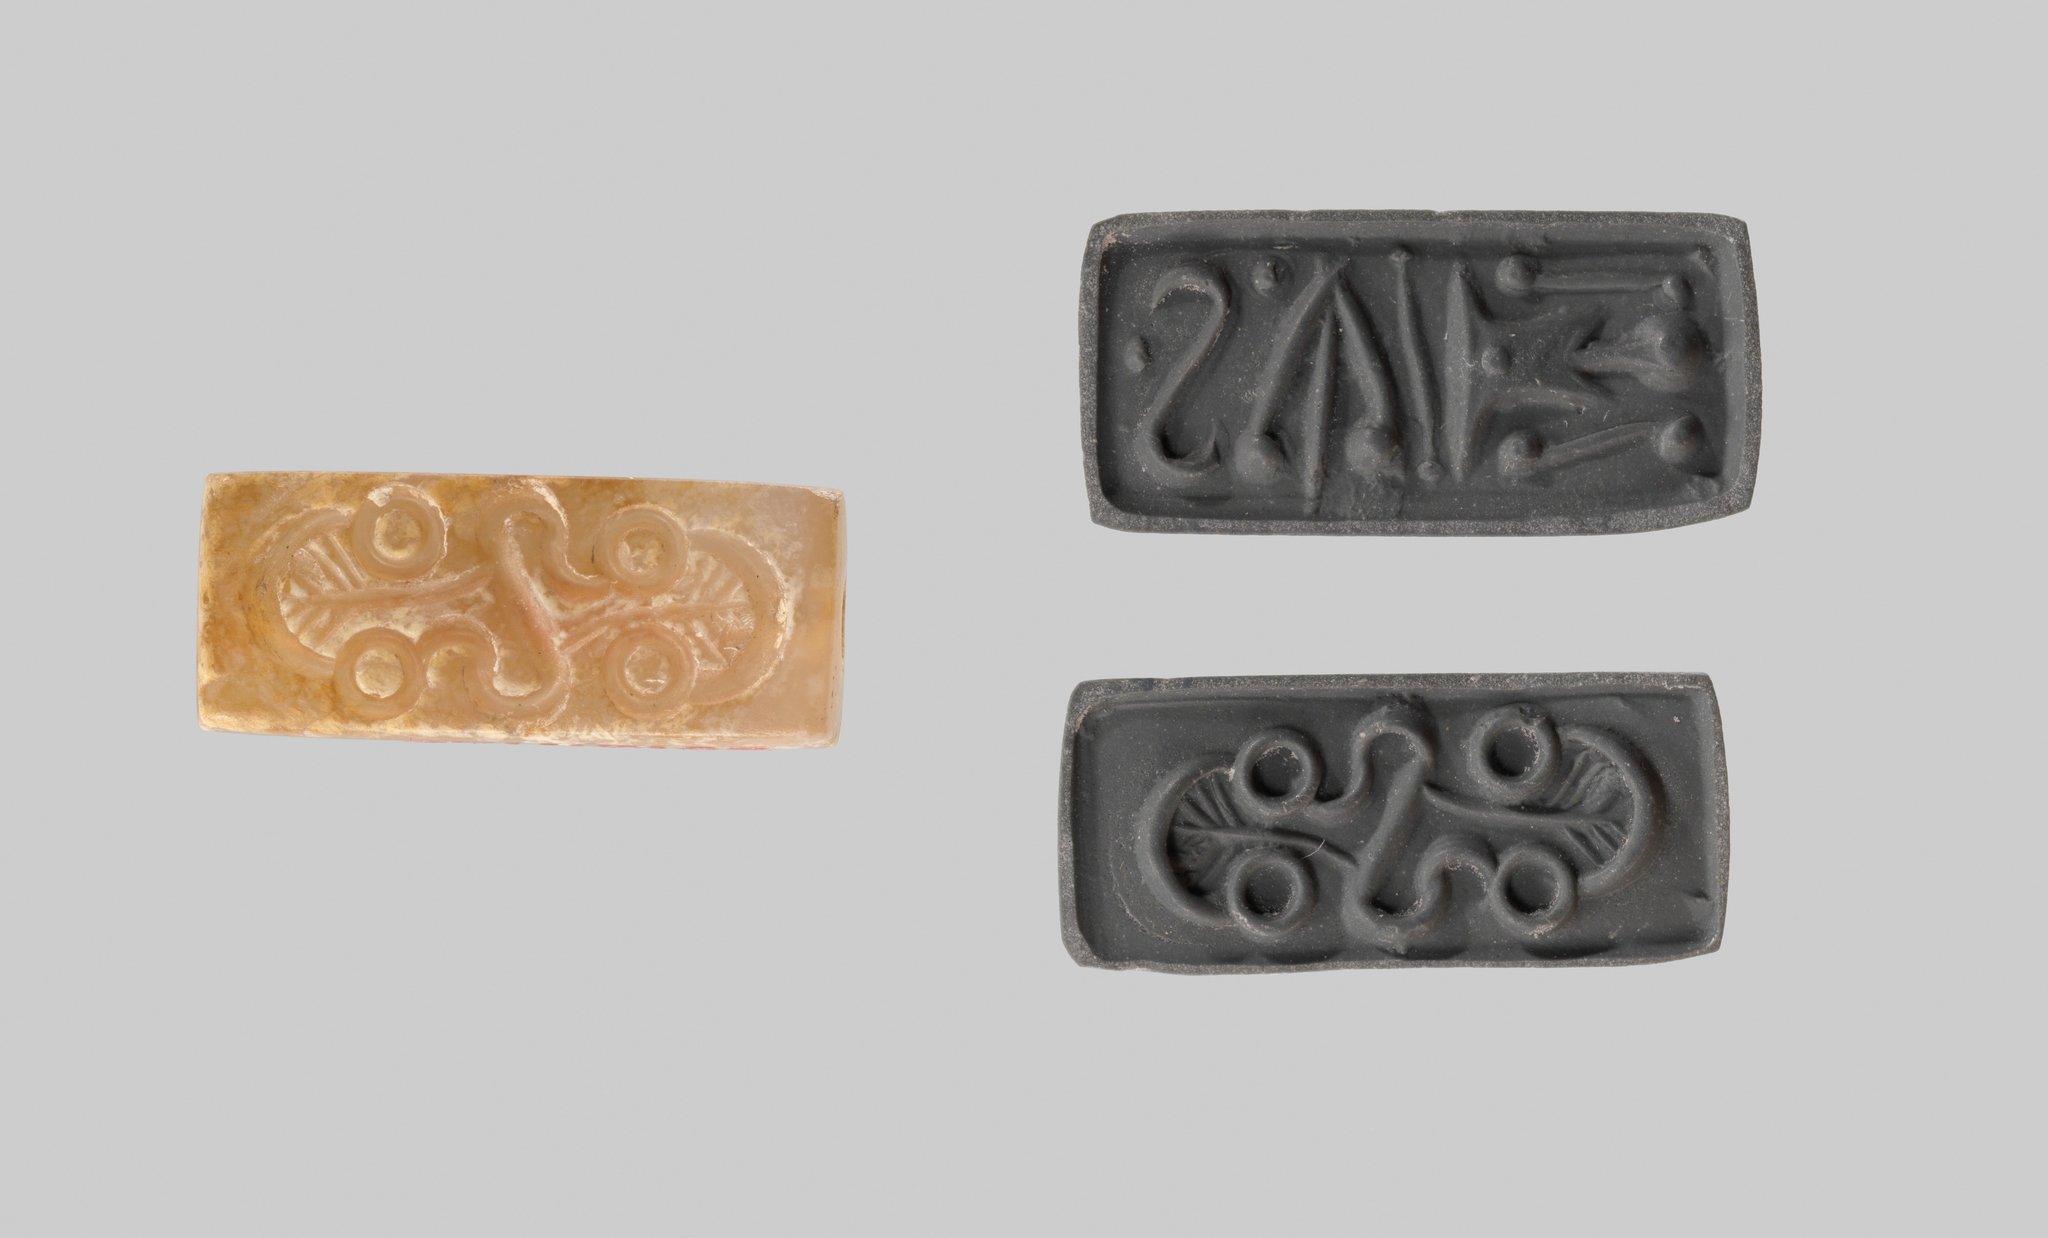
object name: prism, rectangular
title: Agate Rectangular Prism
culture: minoan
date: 1800-1700 BCE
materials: stone